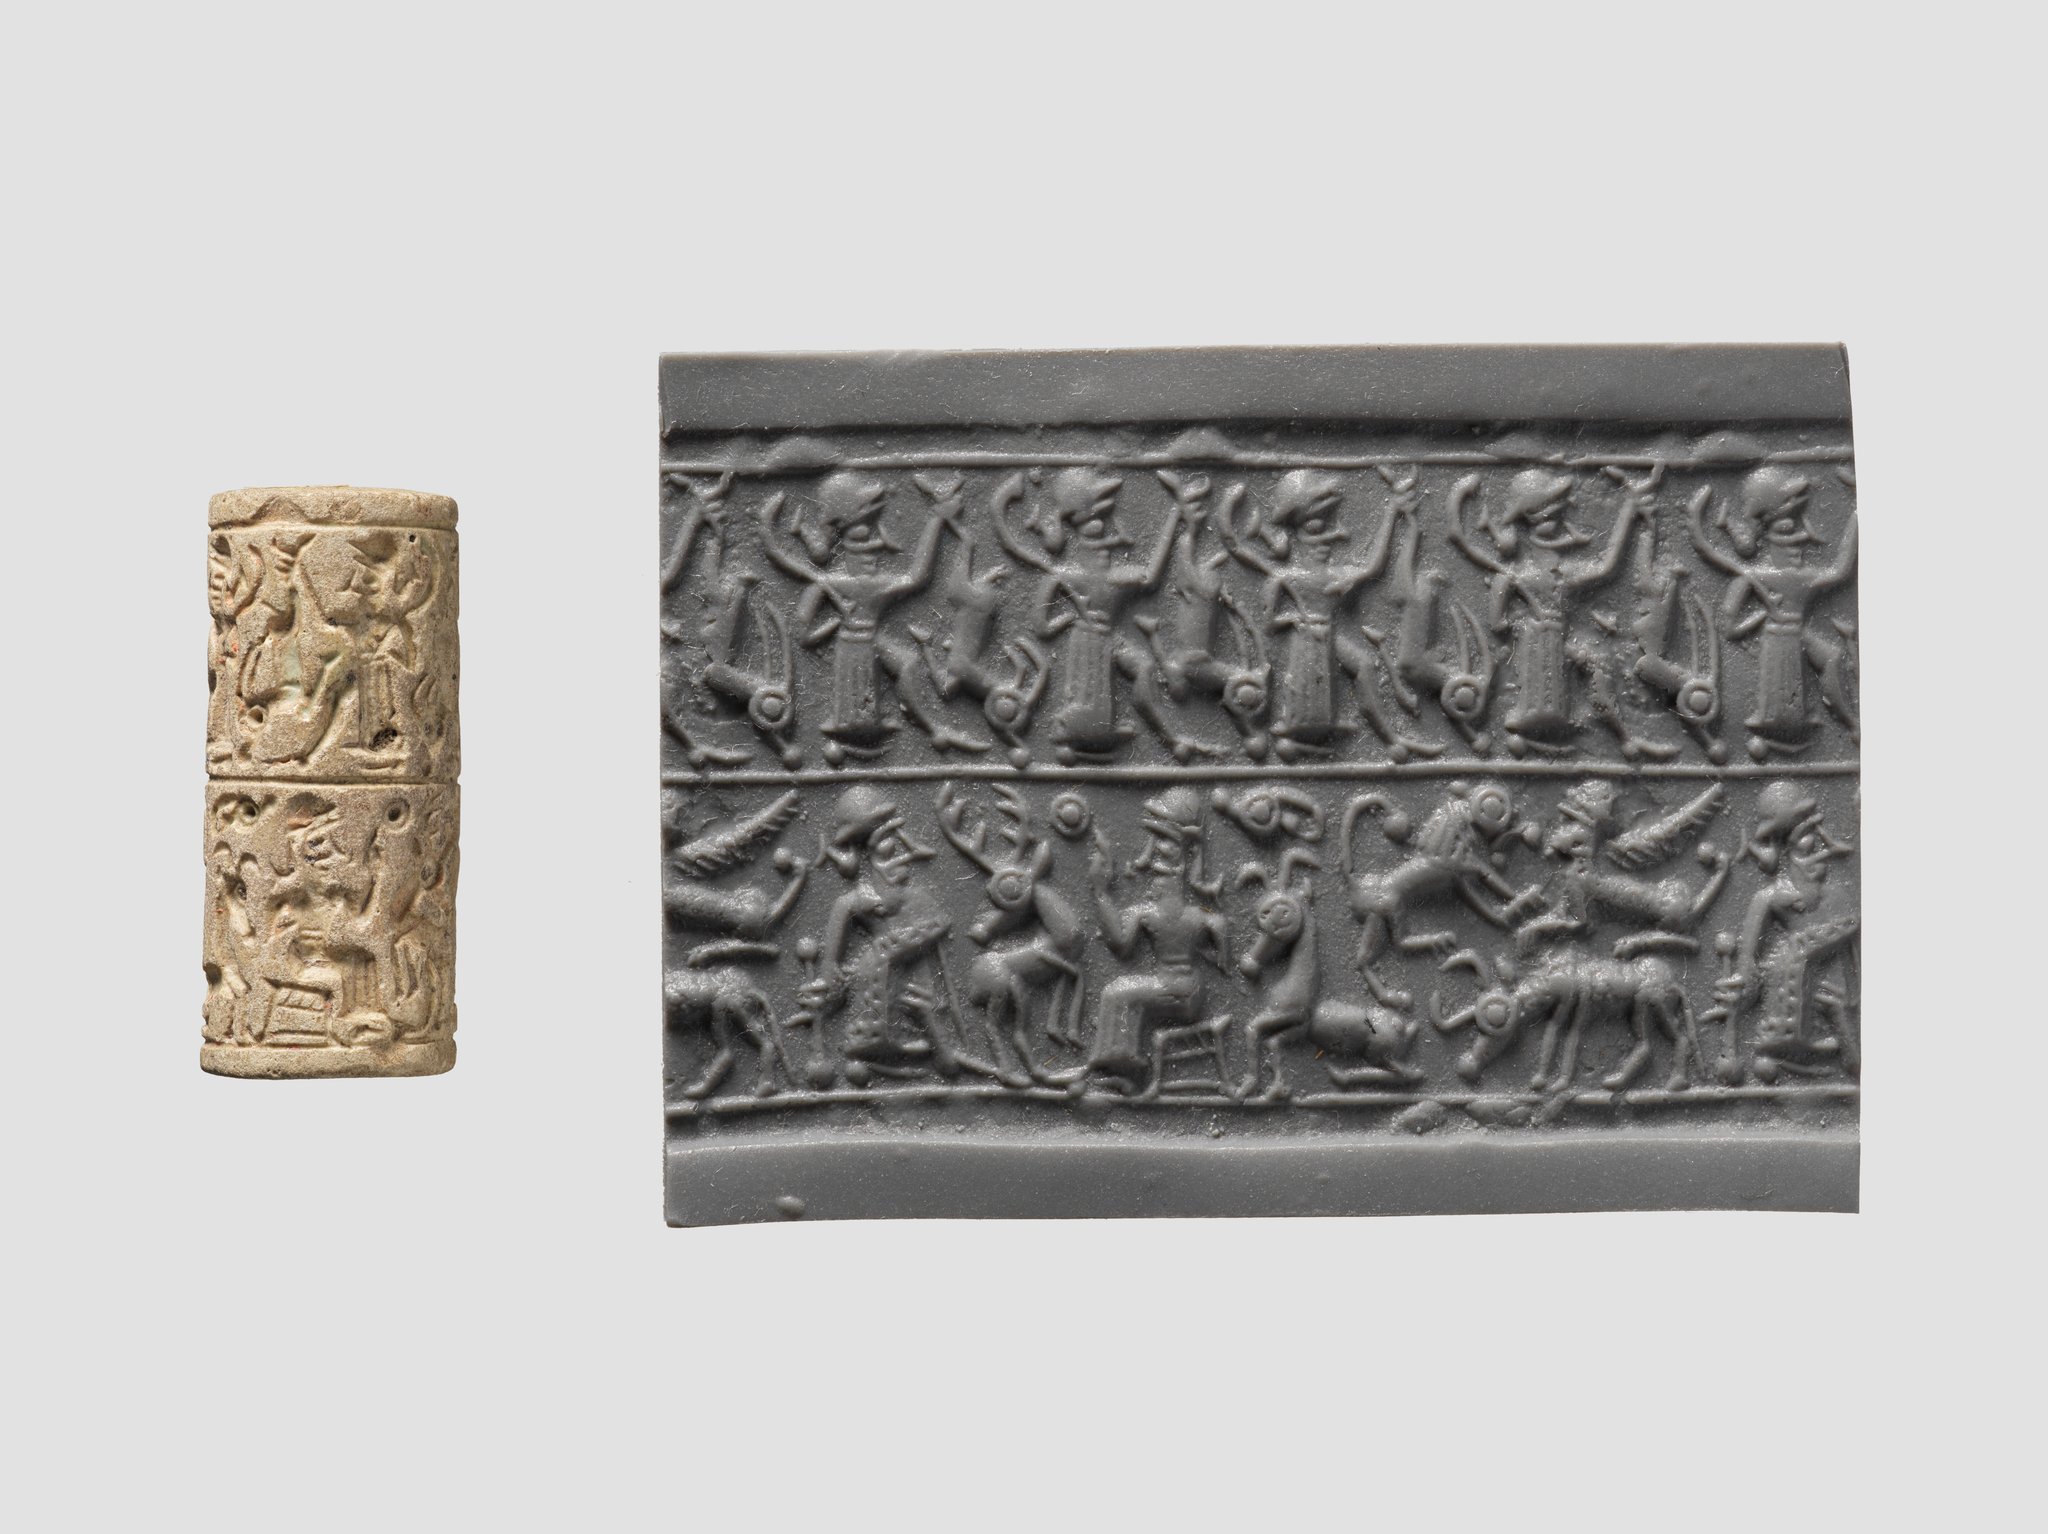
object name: cylinder seal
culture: mitanni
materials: ceramic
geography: mesopotamia or syria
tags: animals